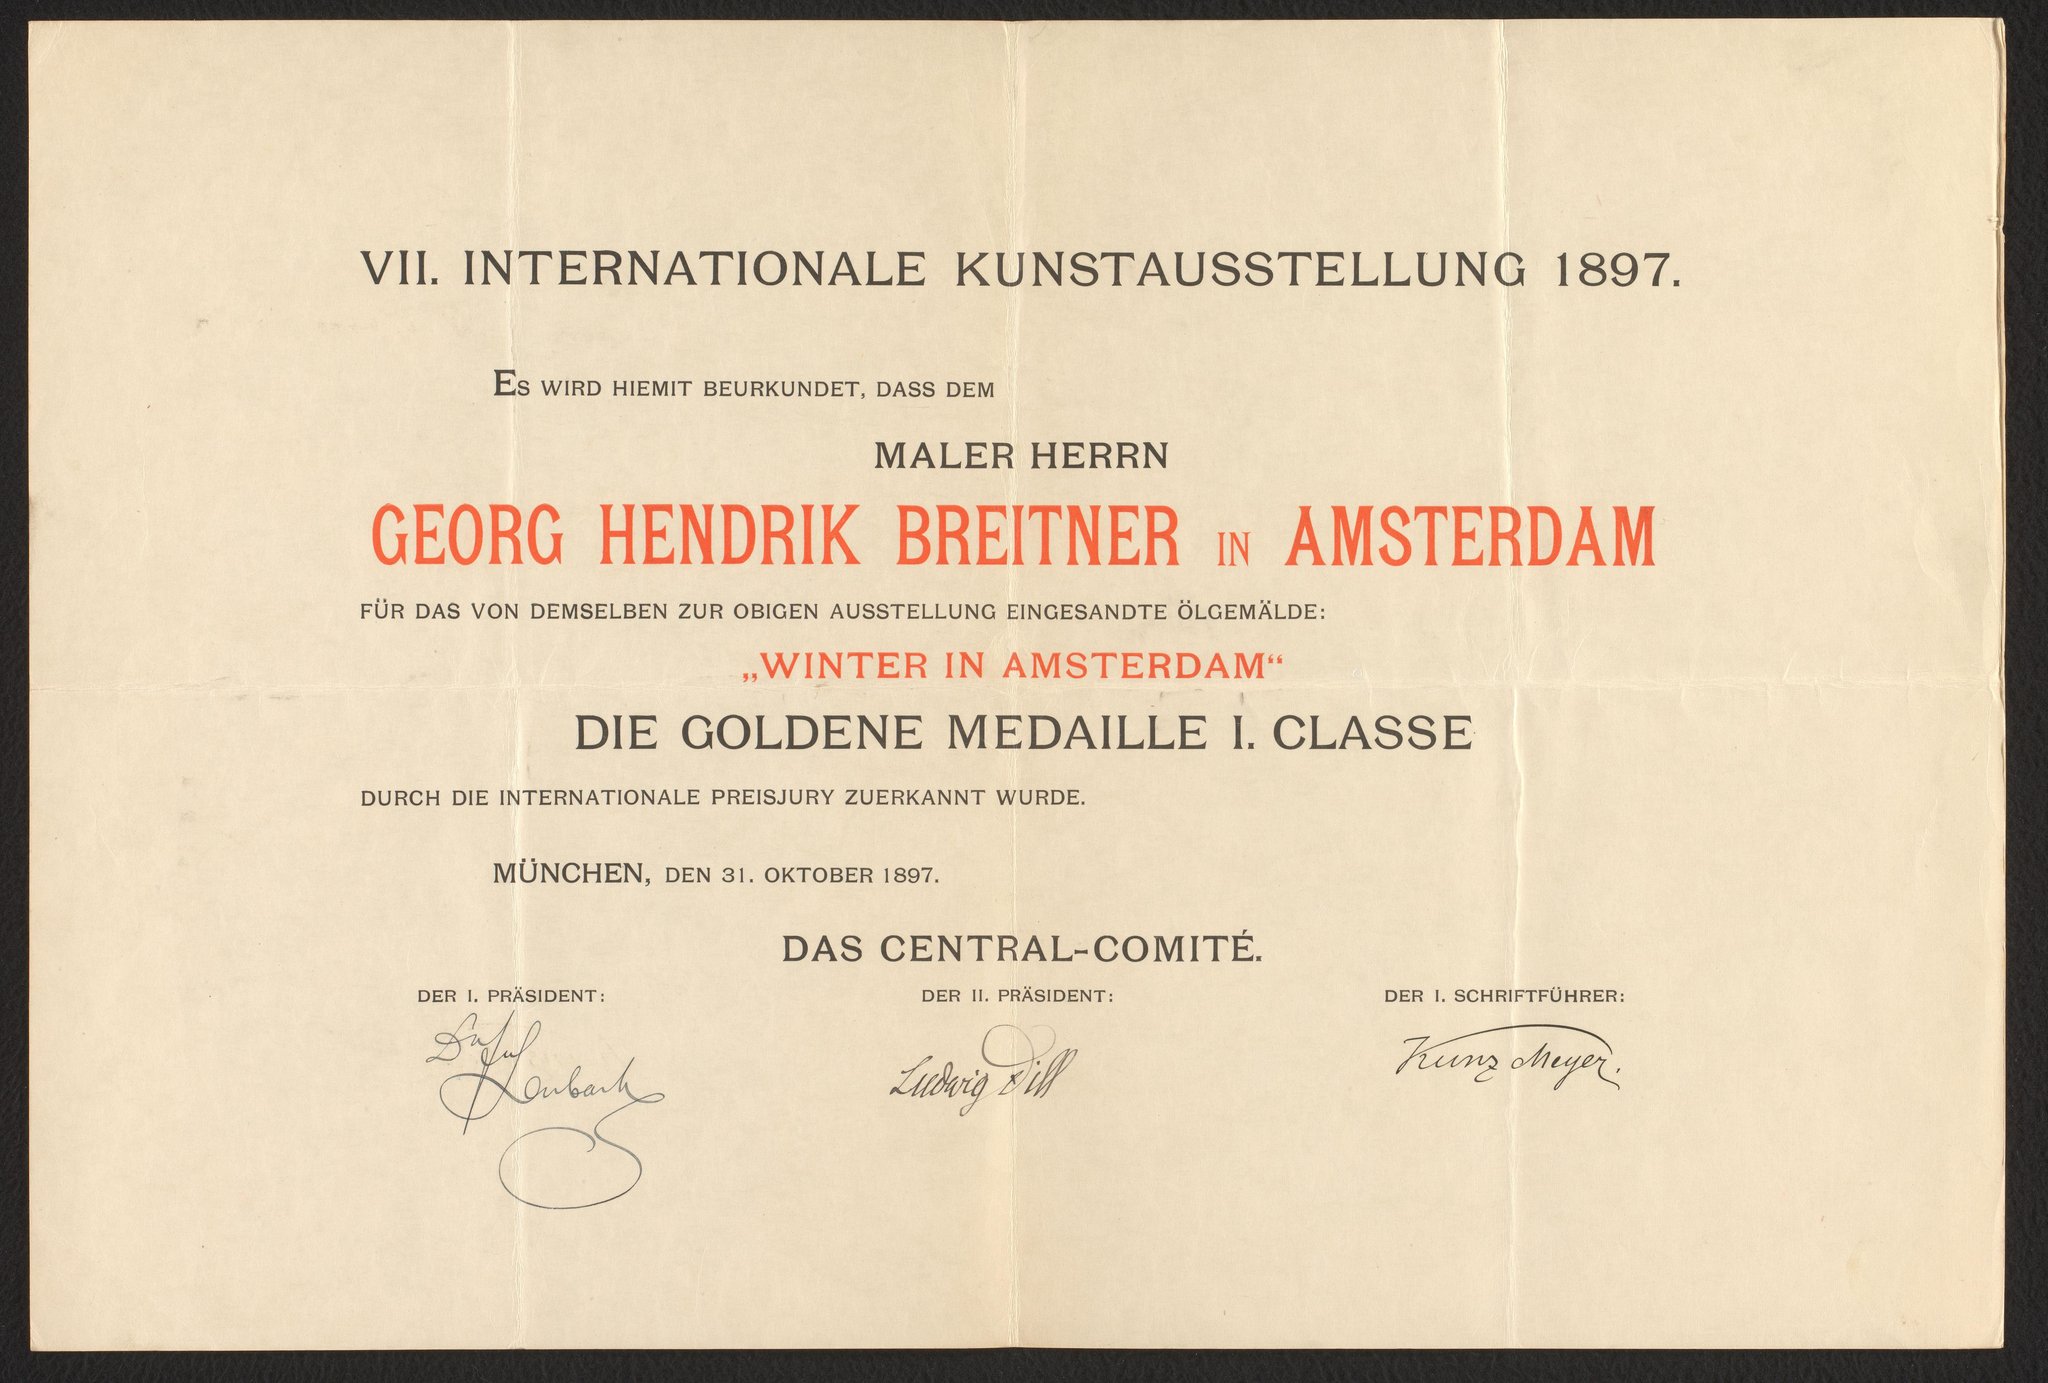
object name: certificate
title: VII. Internationale Kunstaustellung 1897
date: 1897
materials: ink, paper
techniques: letterpress printing, writing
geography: berlin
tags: distribution of awards ~ art contest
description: Diploma voor de gouden medaille tijdens de zevende Internationale Kunst-Ausstellung van 1897 voor het schilderij Winter in Amsterdam. Het diploma is gericht aan de schilder Georg Hendrik Breitner en ondertekend door de eerste president van het comité Hernbach, Ludigwig DIll en Kunz Meyer.